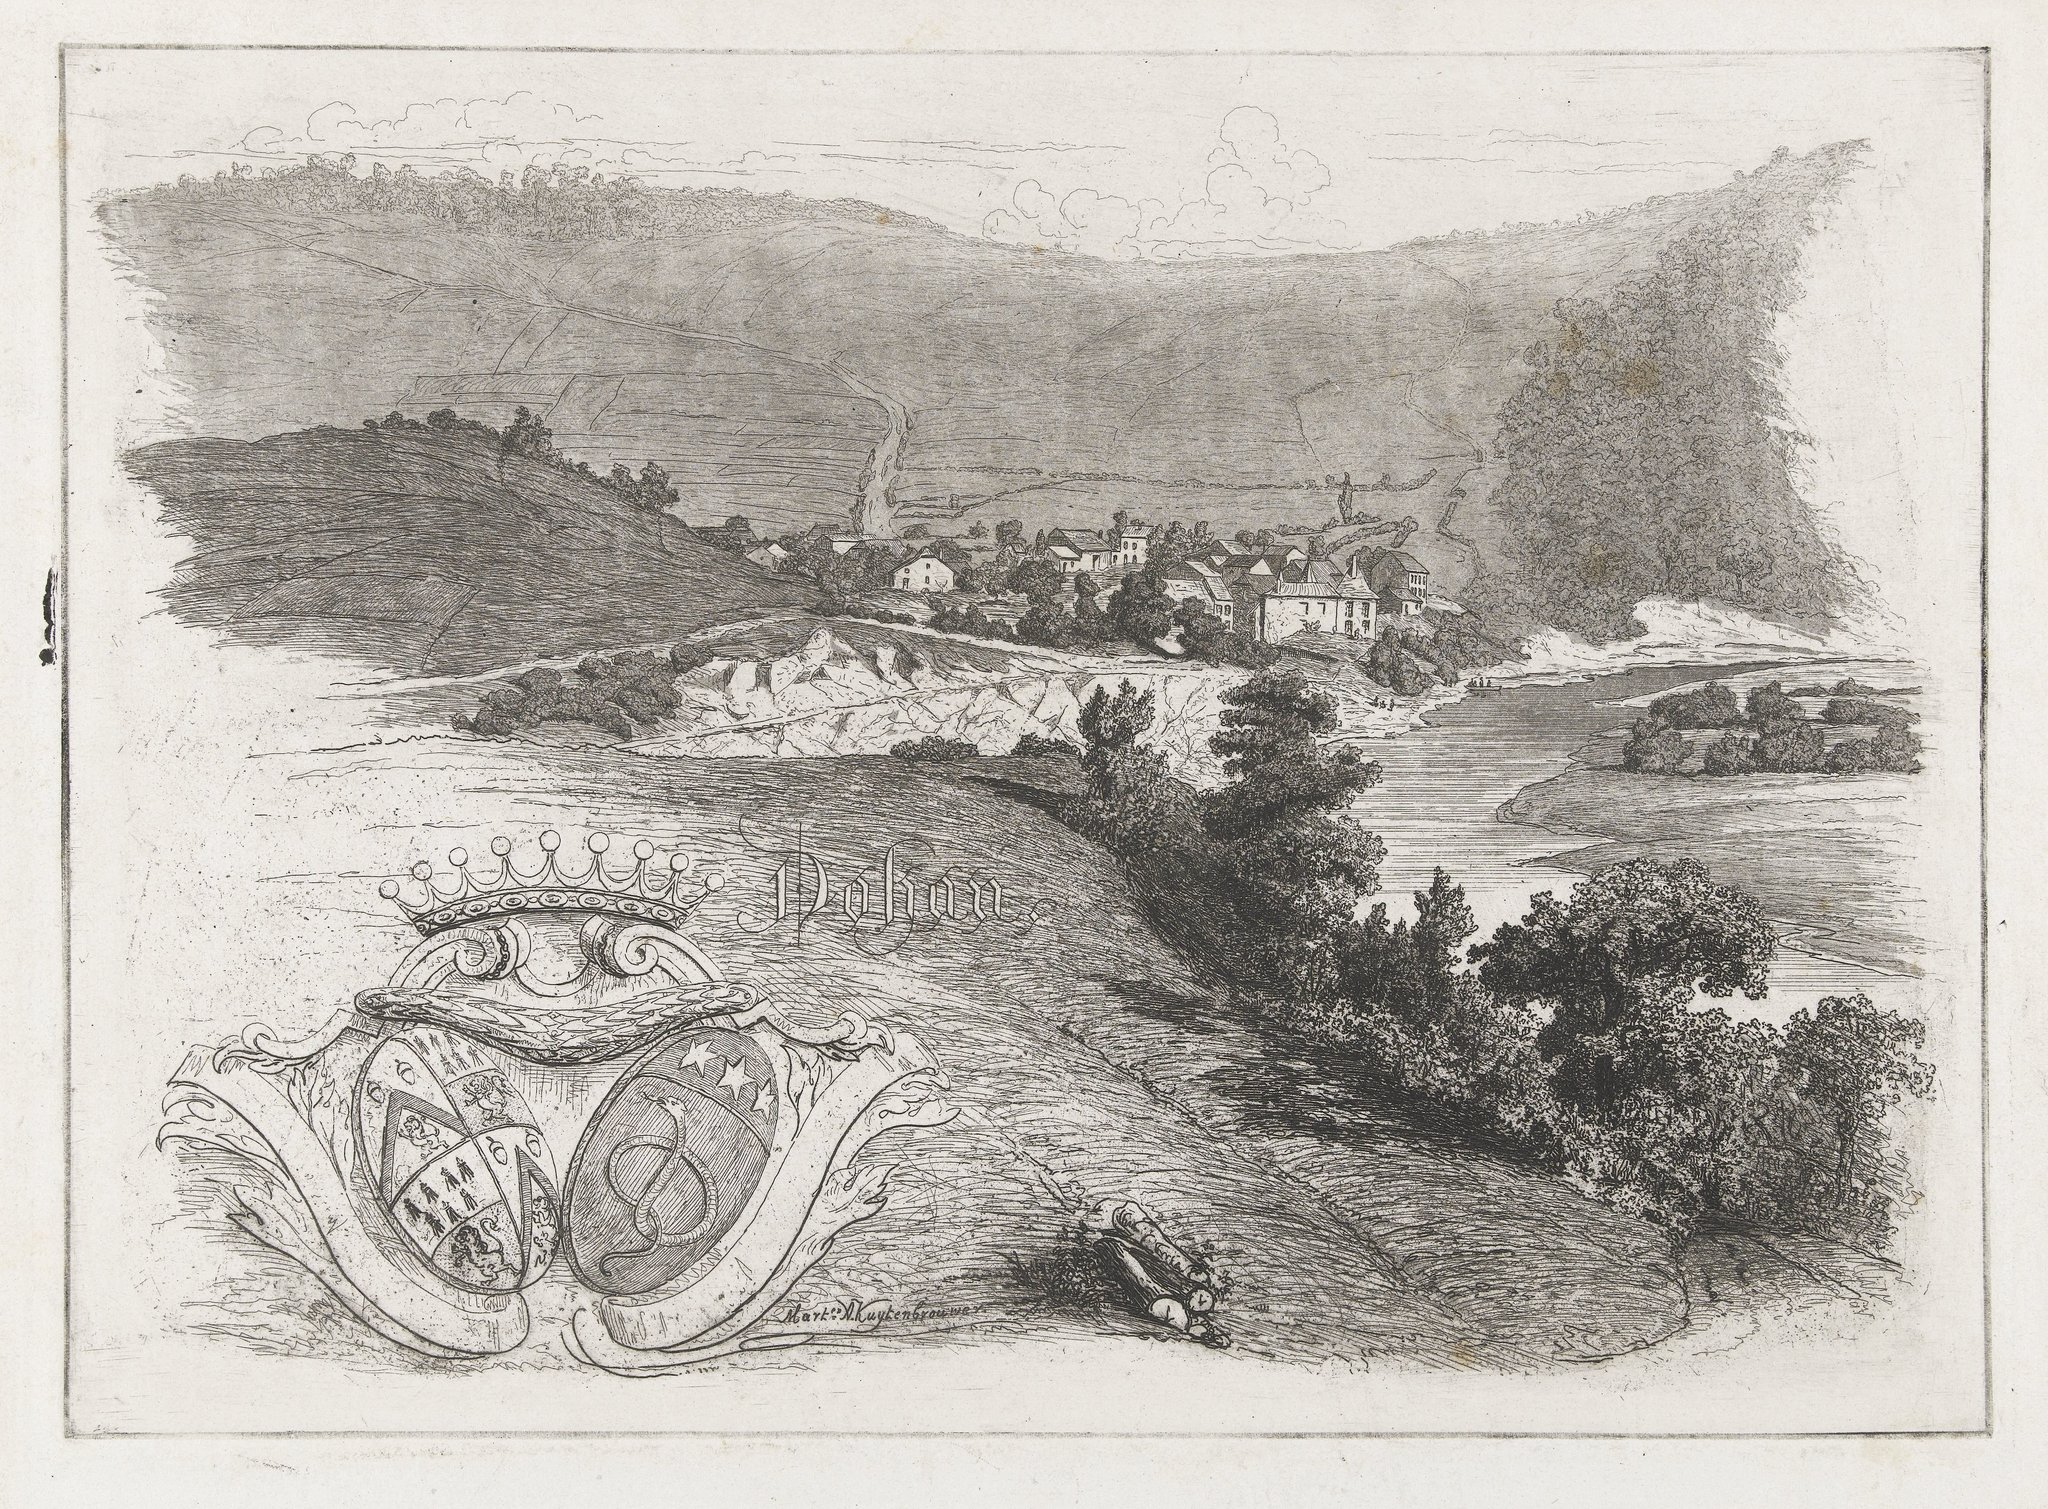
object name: print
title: Dohan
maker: martinus antonius kuytenbrouwer jr.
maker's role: draughtsman, painter, print maker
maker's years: 1821-1897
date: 1831-1897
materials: paper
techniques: drypoint, etching, intaglio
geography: netherlands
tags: low hill country, river, village, belgium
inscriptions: collector's mark: Lugt 2228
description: proefdruk van een illustratie voor: Alexis Victor Joly, Les Ardennes, Brussel: J. van Bruggenhoudt, 1854-1857.